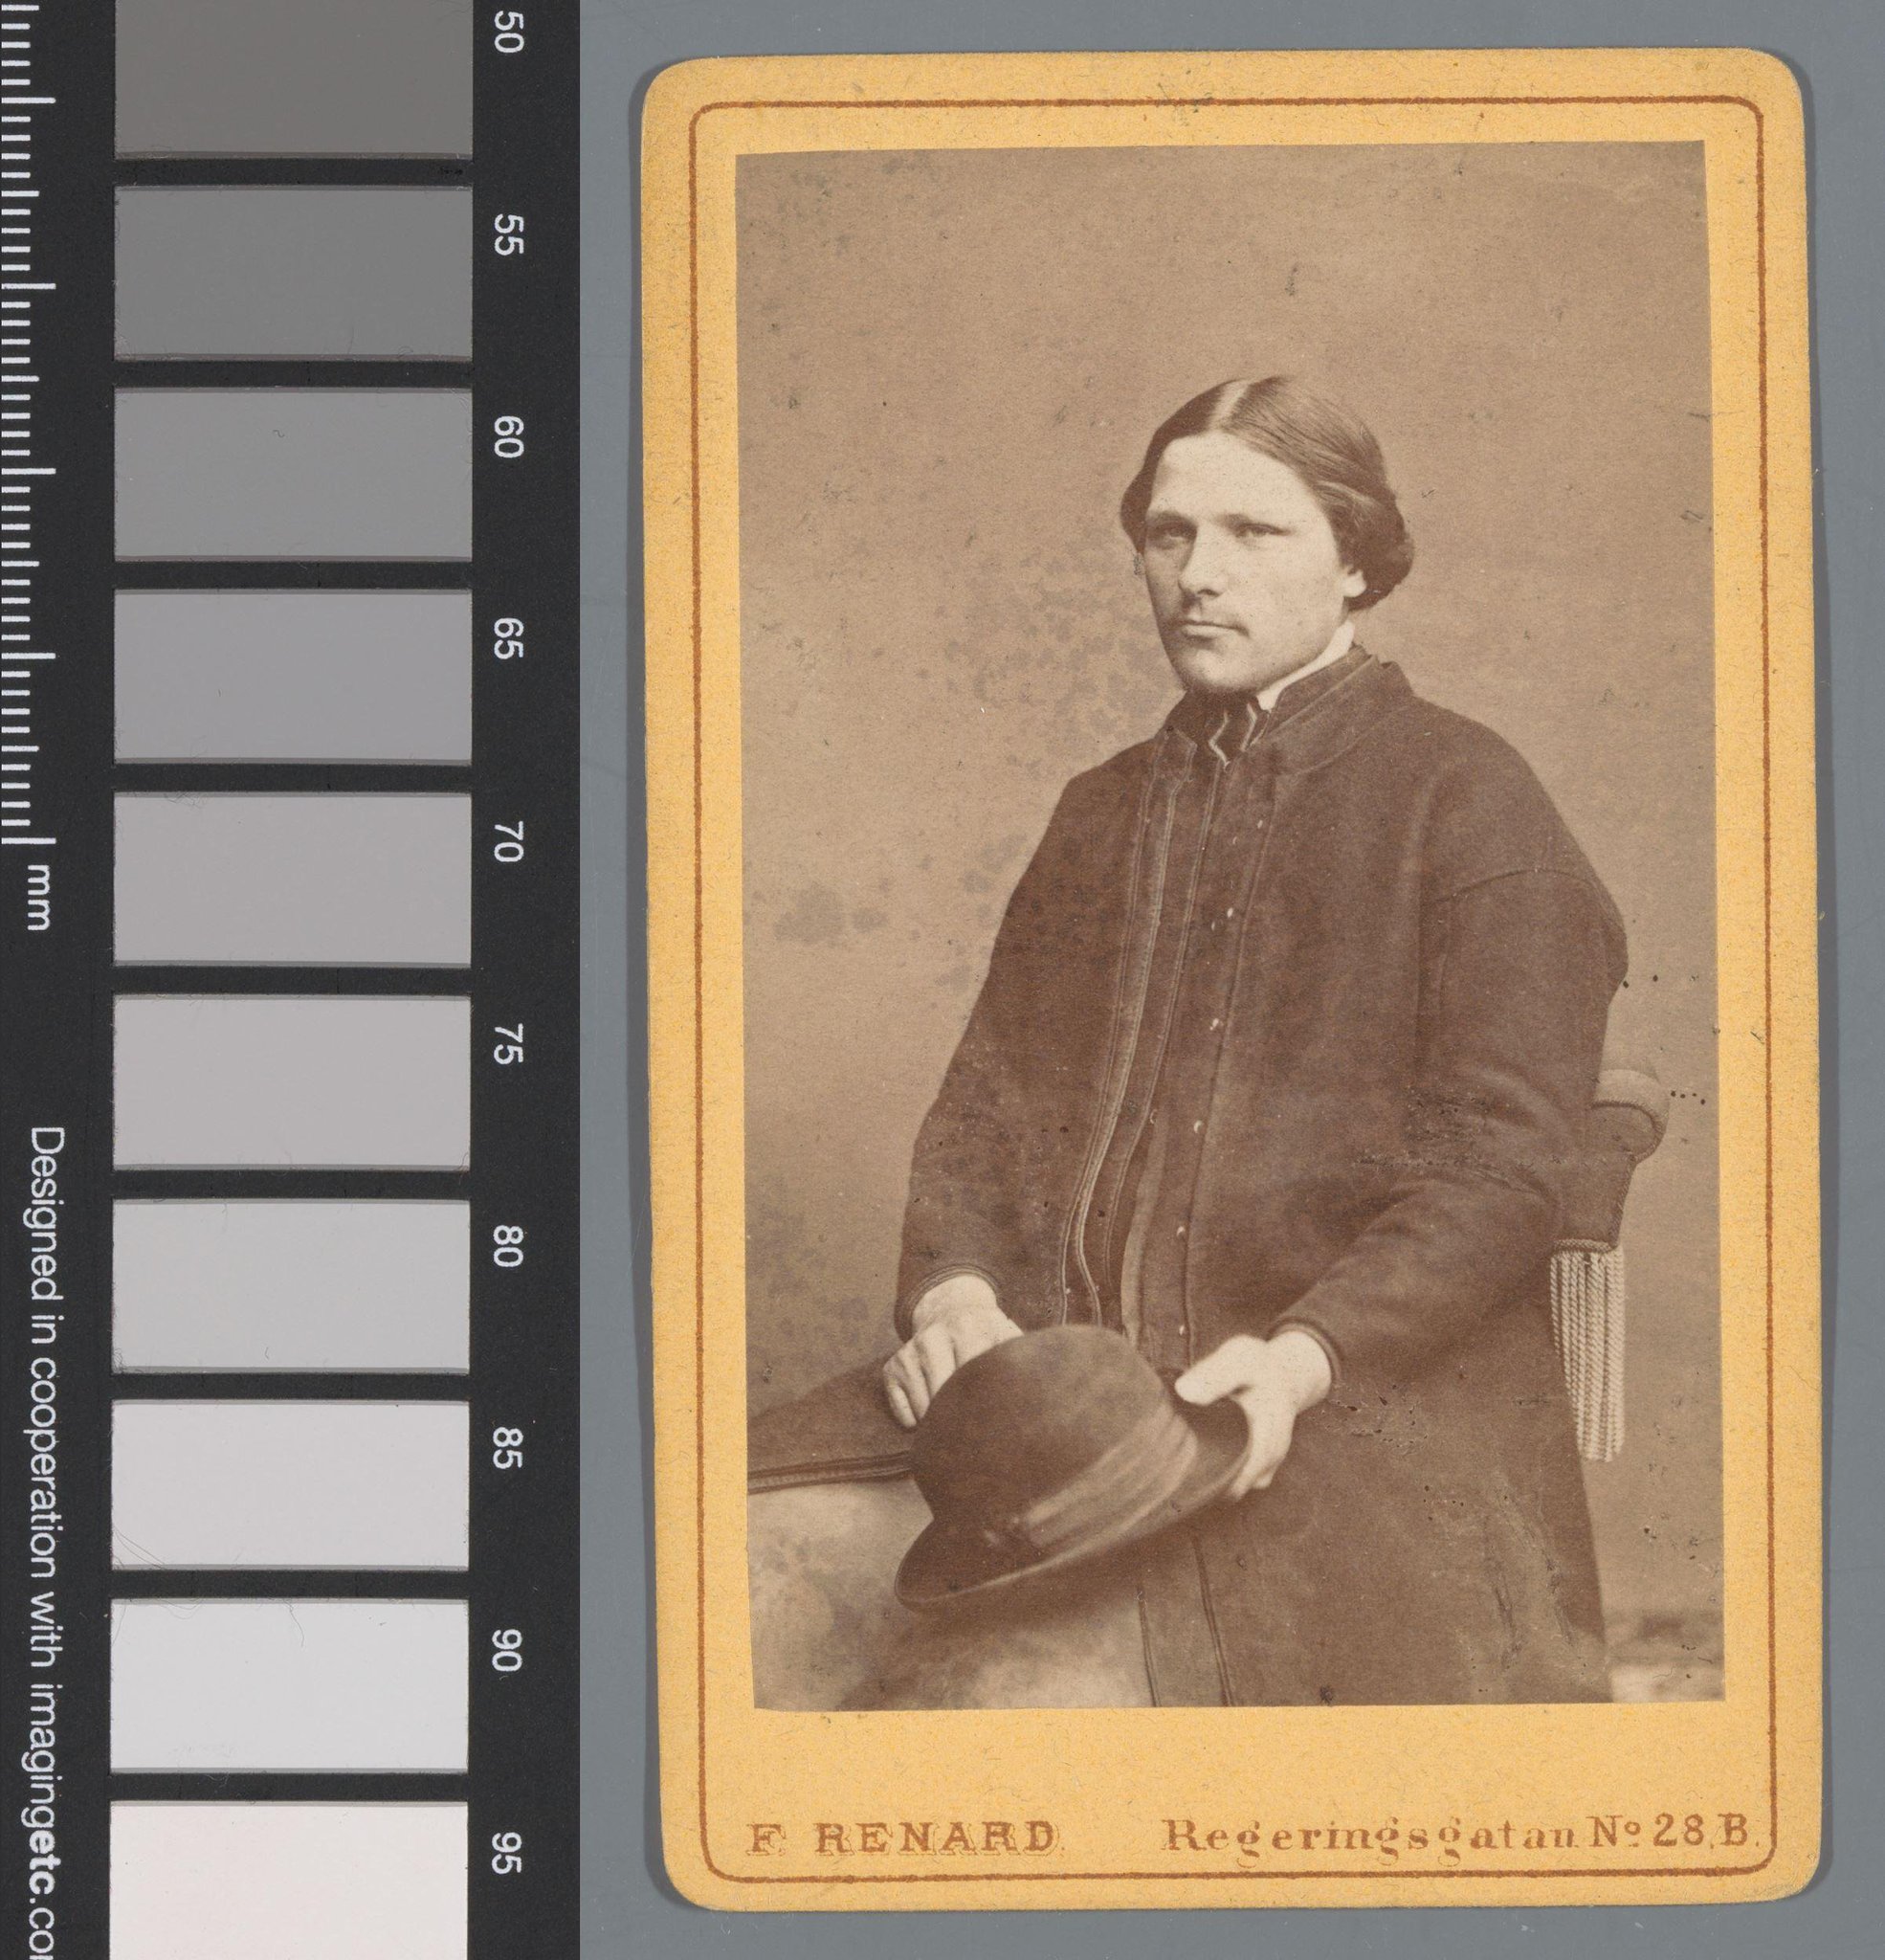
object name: photograph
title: Portret van een onbekende man met hoed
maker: frederik renard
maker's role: fotograaf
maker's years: 1824-1895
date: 1865-1880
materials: cardboard, paper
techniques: albumen print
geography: stockholm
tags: adult man, anonymous historical person portrayed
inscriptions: inscription: ‘Plåten förvaras för efterbeställning.’, address: ‘Stockholm/ Regeringsgatan No 28, B.’